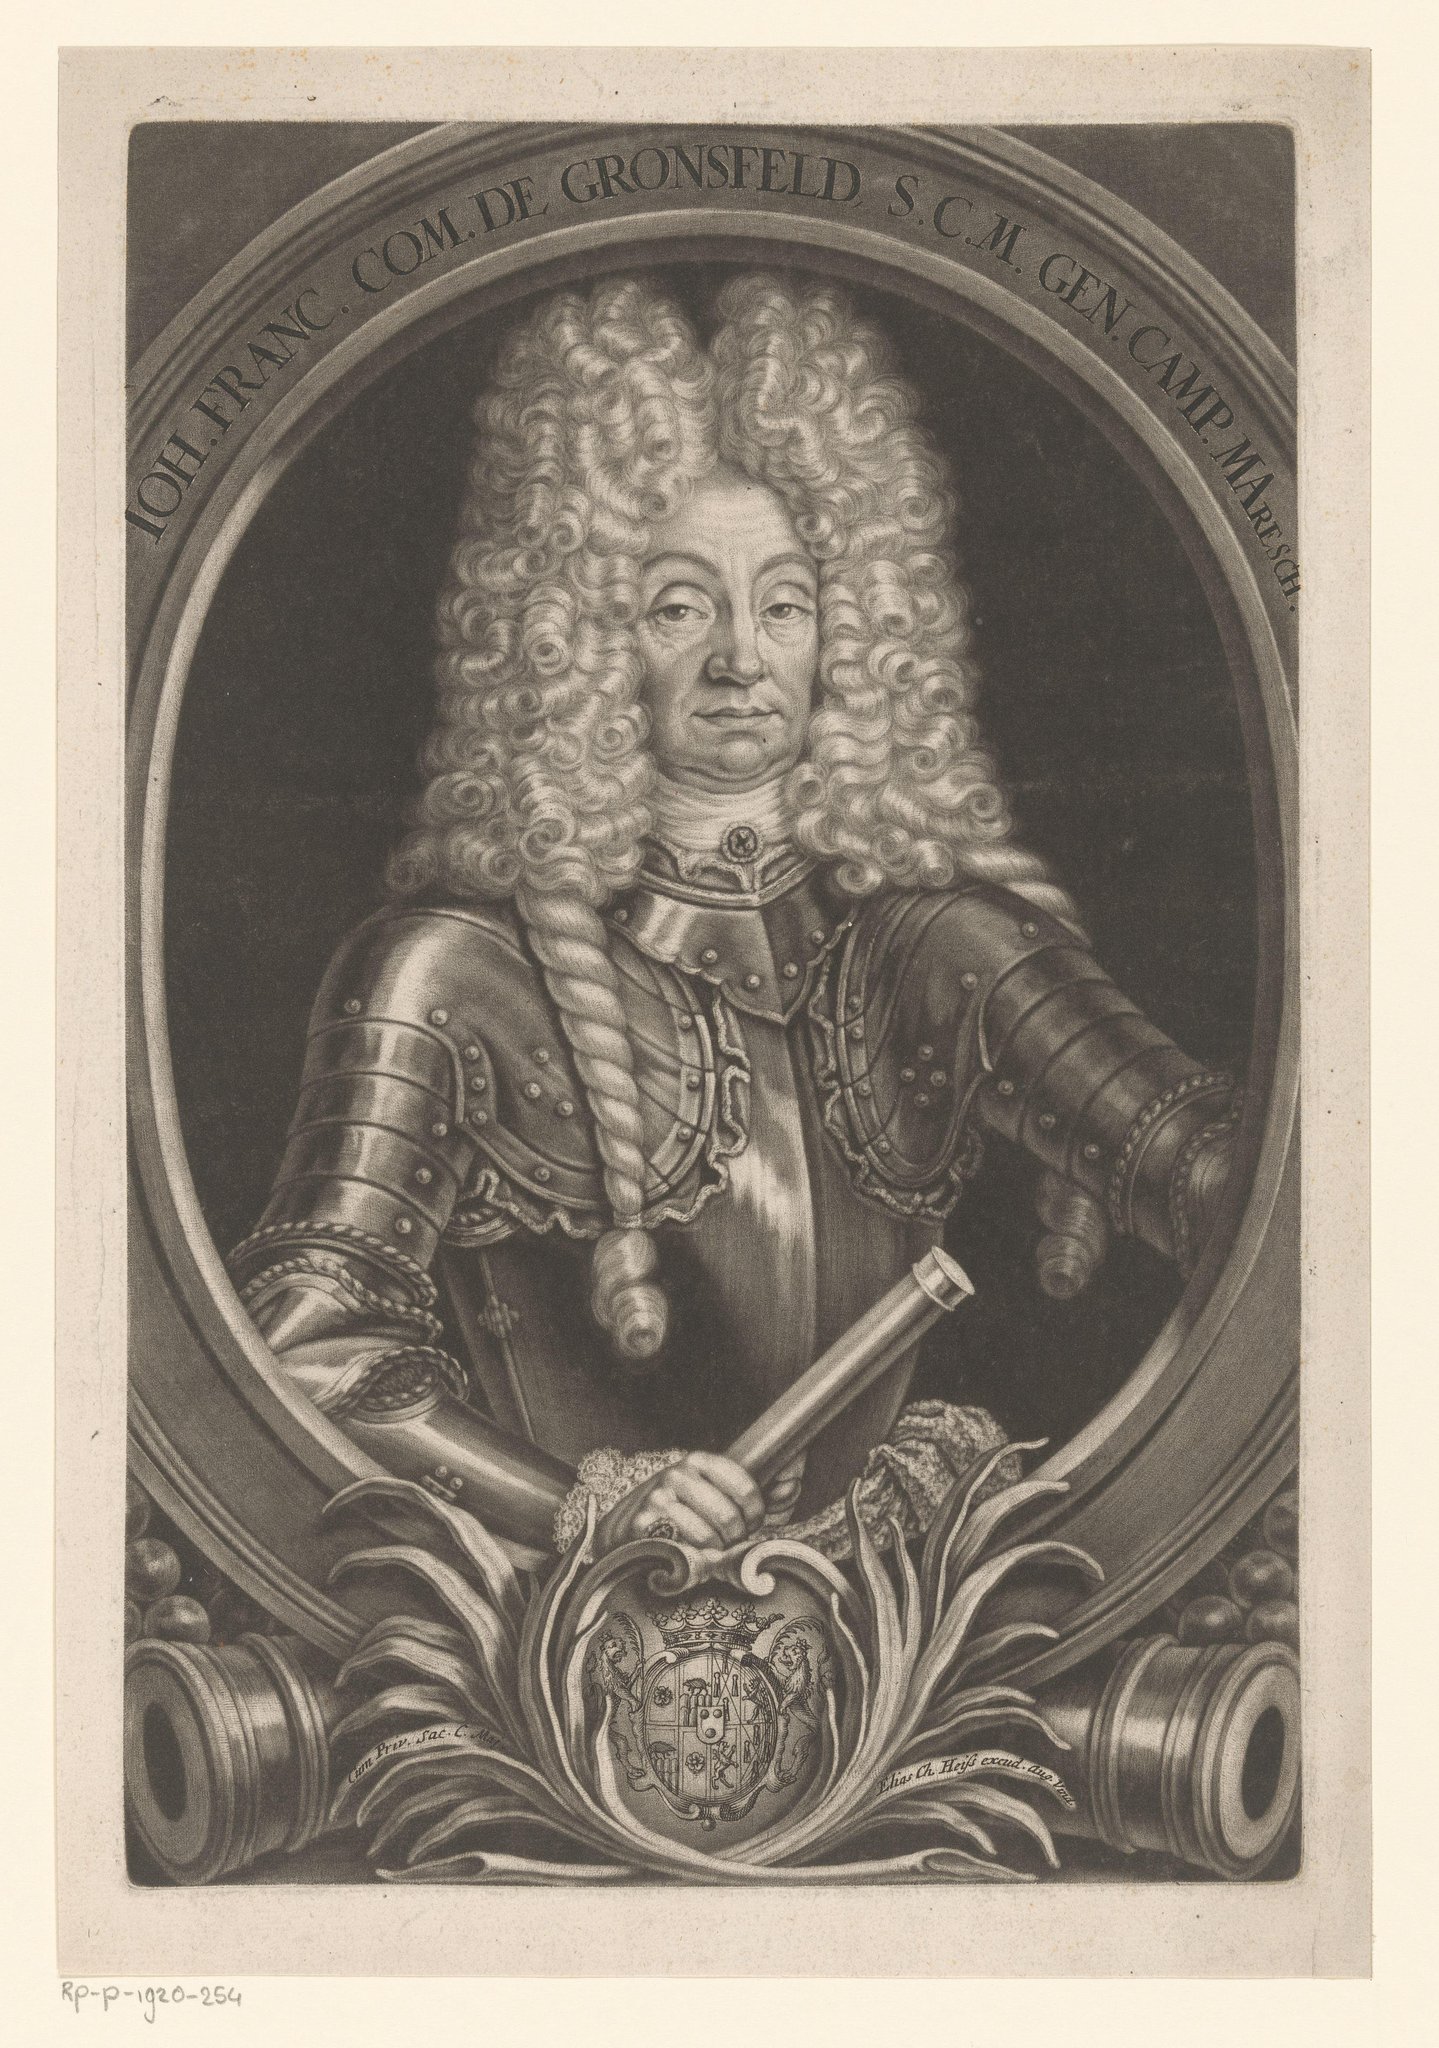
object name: print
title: Portret van Johann Franz von Bronckhorst und Gronsfeld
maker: elias christopf heiss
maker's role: painter, print maker, publisher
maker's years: 1660-1731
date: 1670-1719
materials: paper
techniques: etching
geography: augsburg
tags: historical persons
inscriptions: collector's mark: Lugt 2228